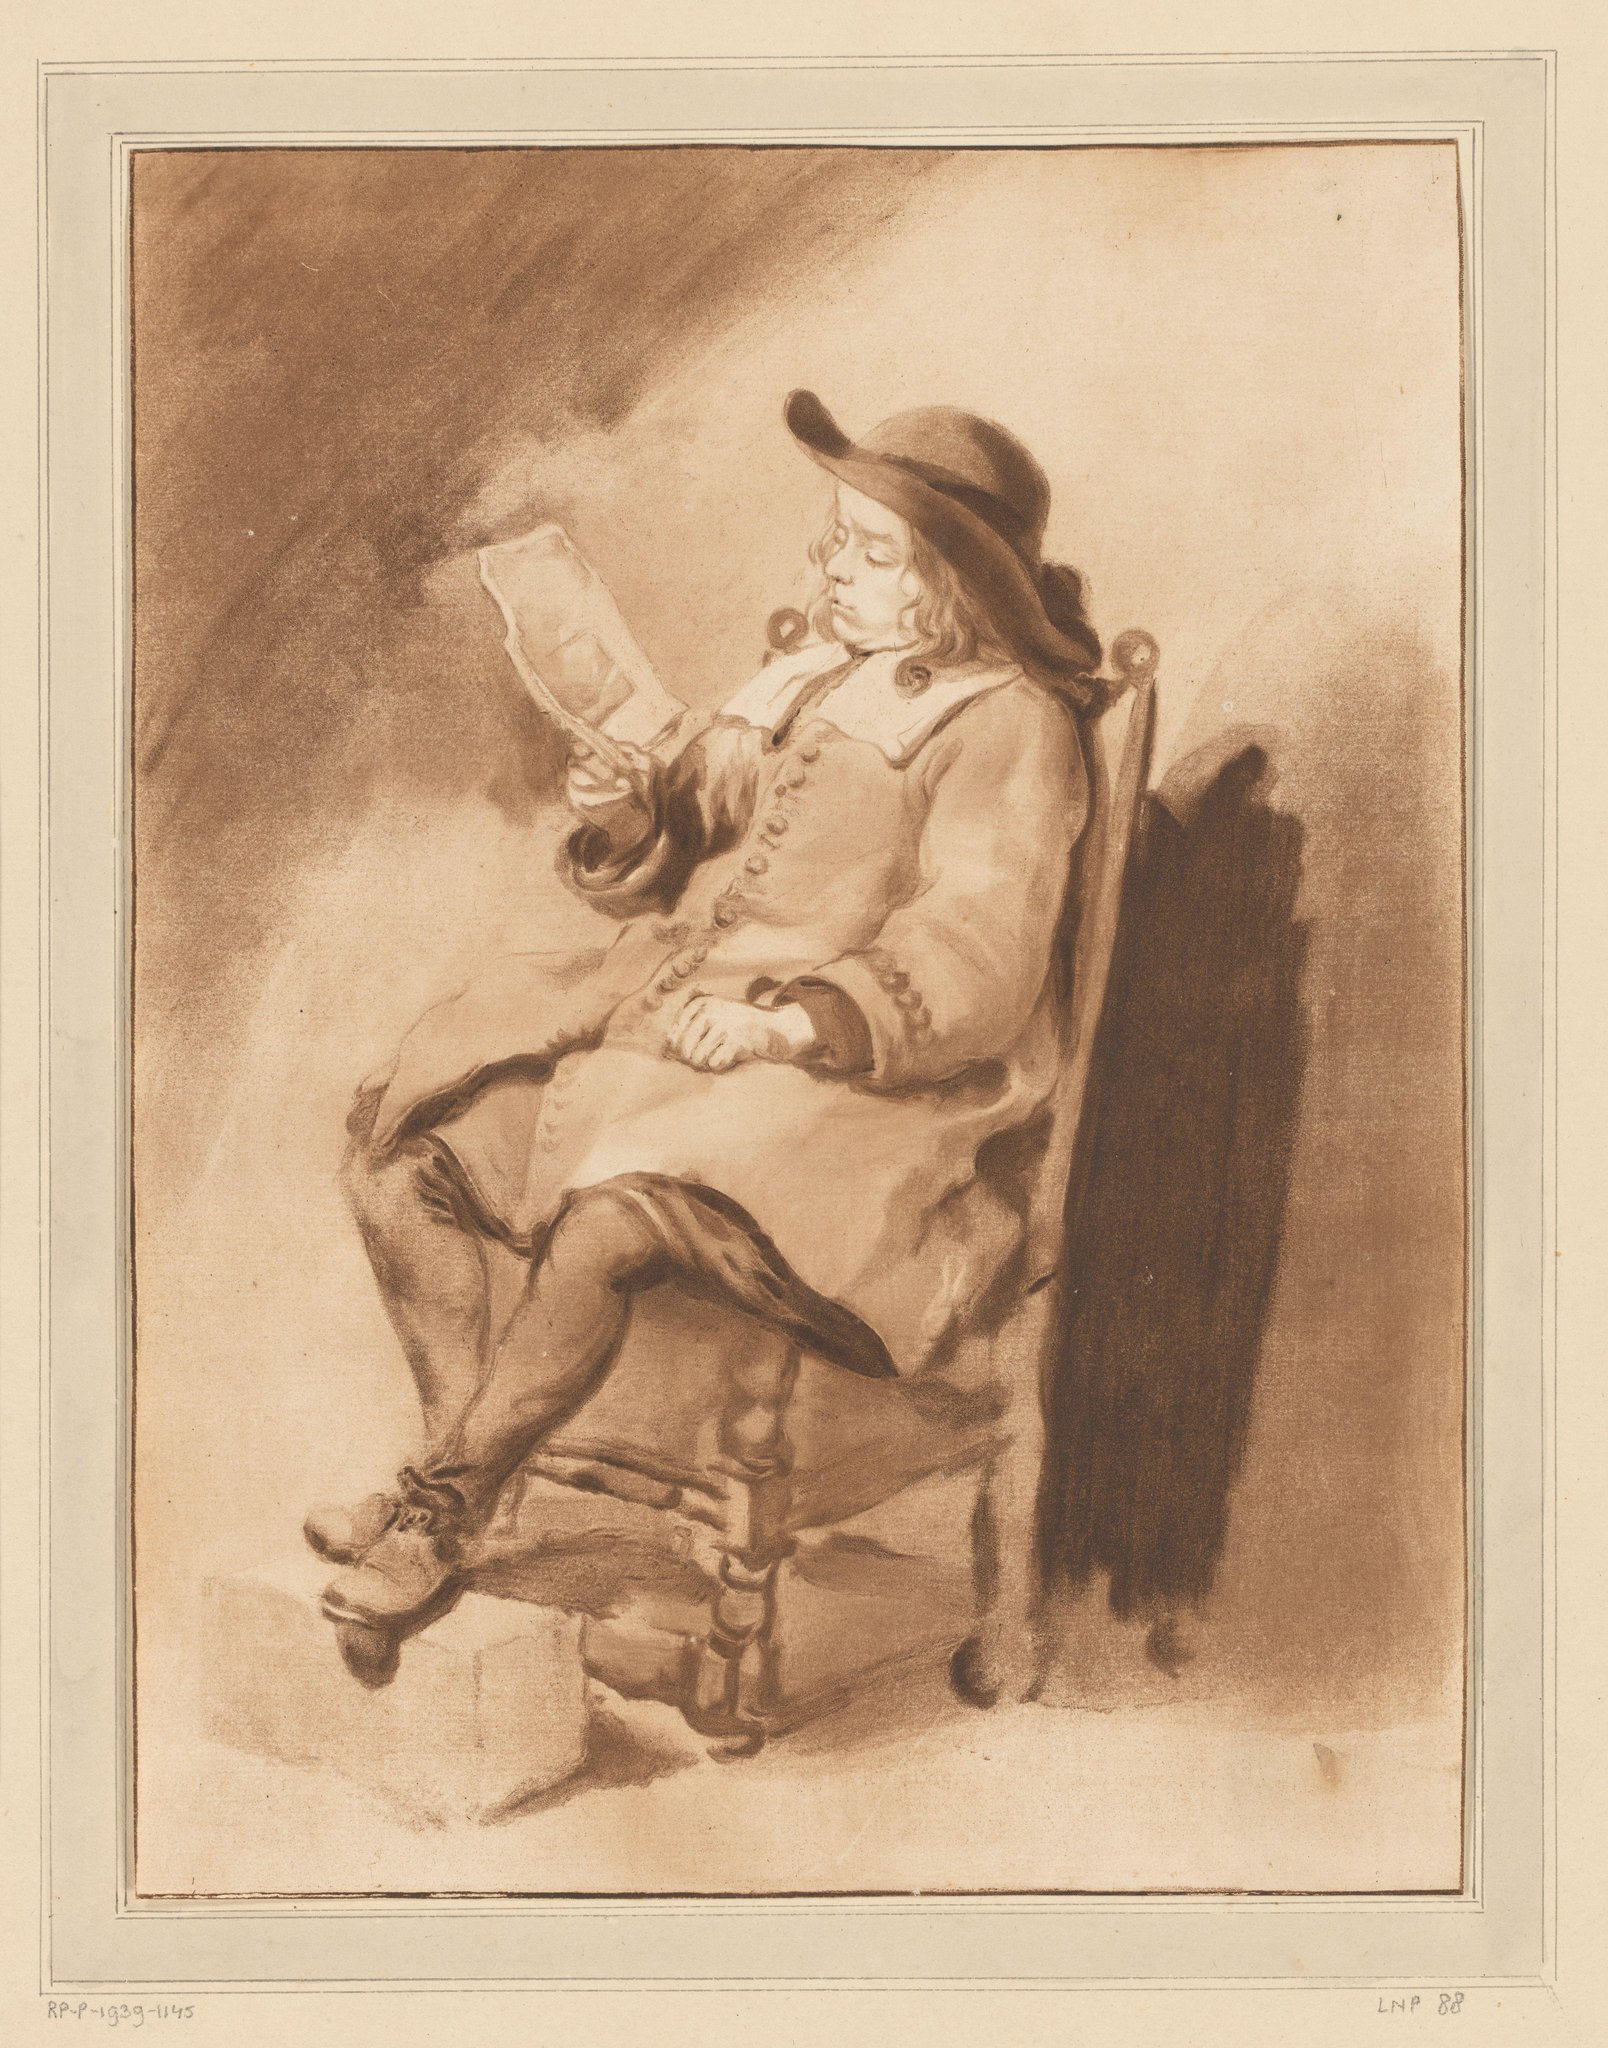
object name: print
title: Lezende jongeling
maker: jurriaan cootwijck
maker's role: print maker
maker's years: 1714-1798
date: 1724-1798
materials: paper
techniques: roulette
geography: amsterdam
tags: reading, youth, adolescent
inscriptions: collector's mark: ‘RIJKS / MUSM’, inscription: ‘J. Cootwijk Fecit’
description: De prent werd opgenomen in: Collection d'imitations de dessins d'après les principaux maîtres hollandais et flamands, Londen, C. Josi, 1821.